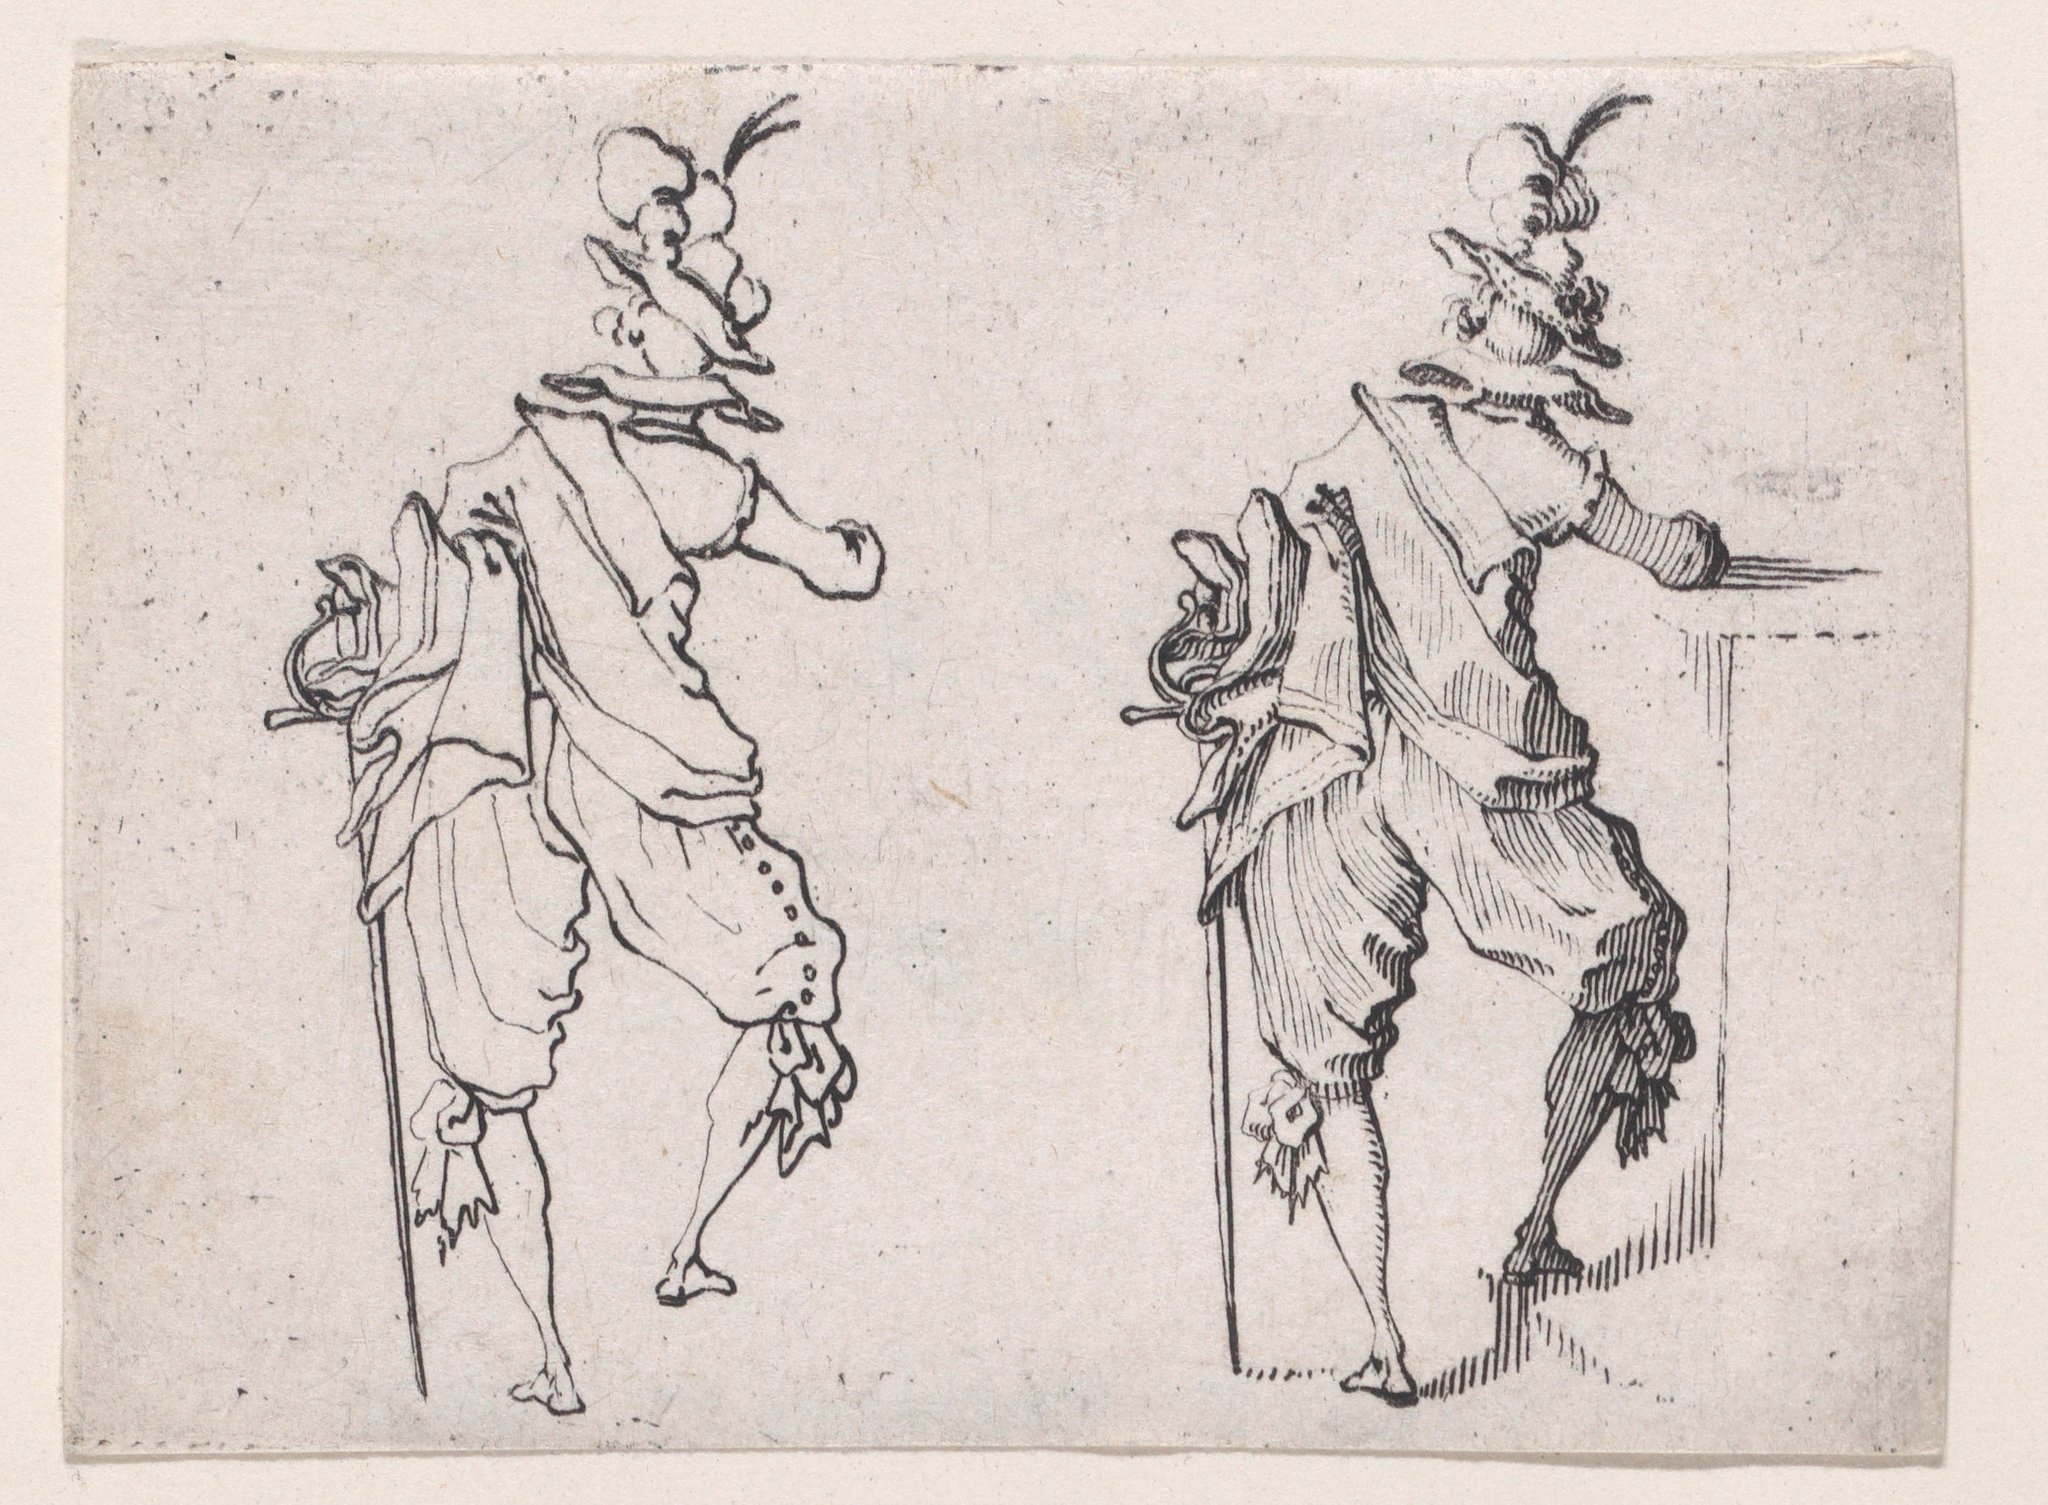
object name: print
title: L'Homme Vue de Dos Avec une Grande Épée (Man Seen from Behind with a Large Sword), from "Les Caprices" Series A, The Florence Set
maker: jacques callot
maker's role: artist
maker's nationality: french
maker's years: 1592-1635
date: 1617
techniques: etching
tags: swords,men